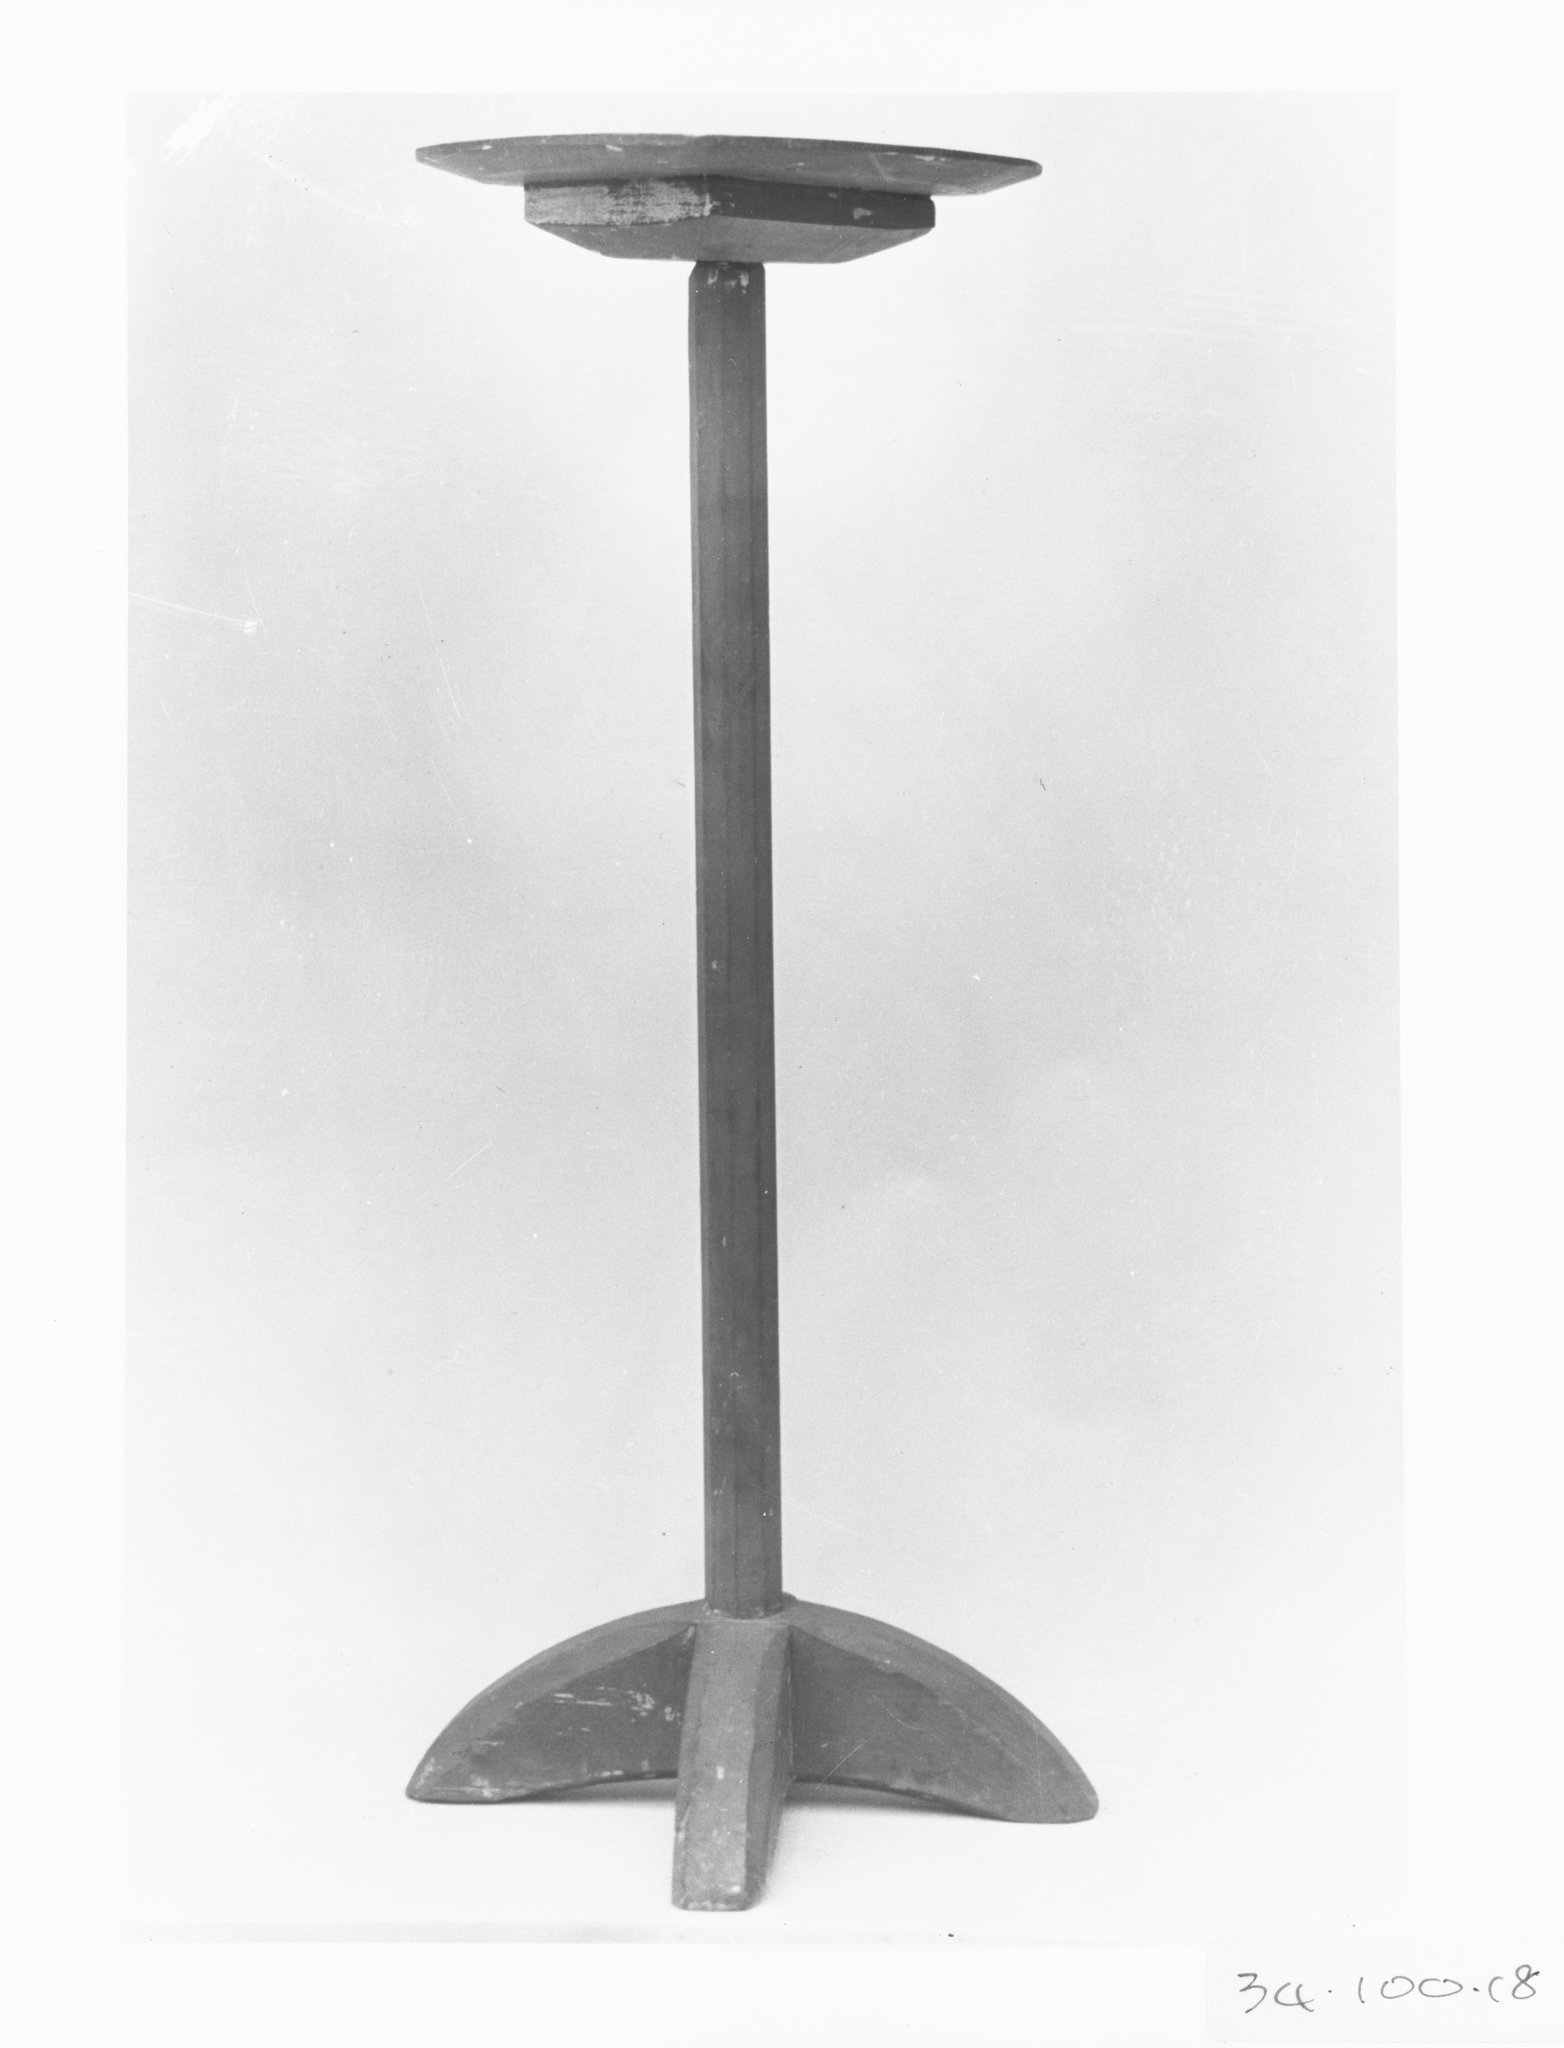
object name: candle stand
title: Candlestand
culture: american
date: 1700-1750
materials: wood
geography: united states